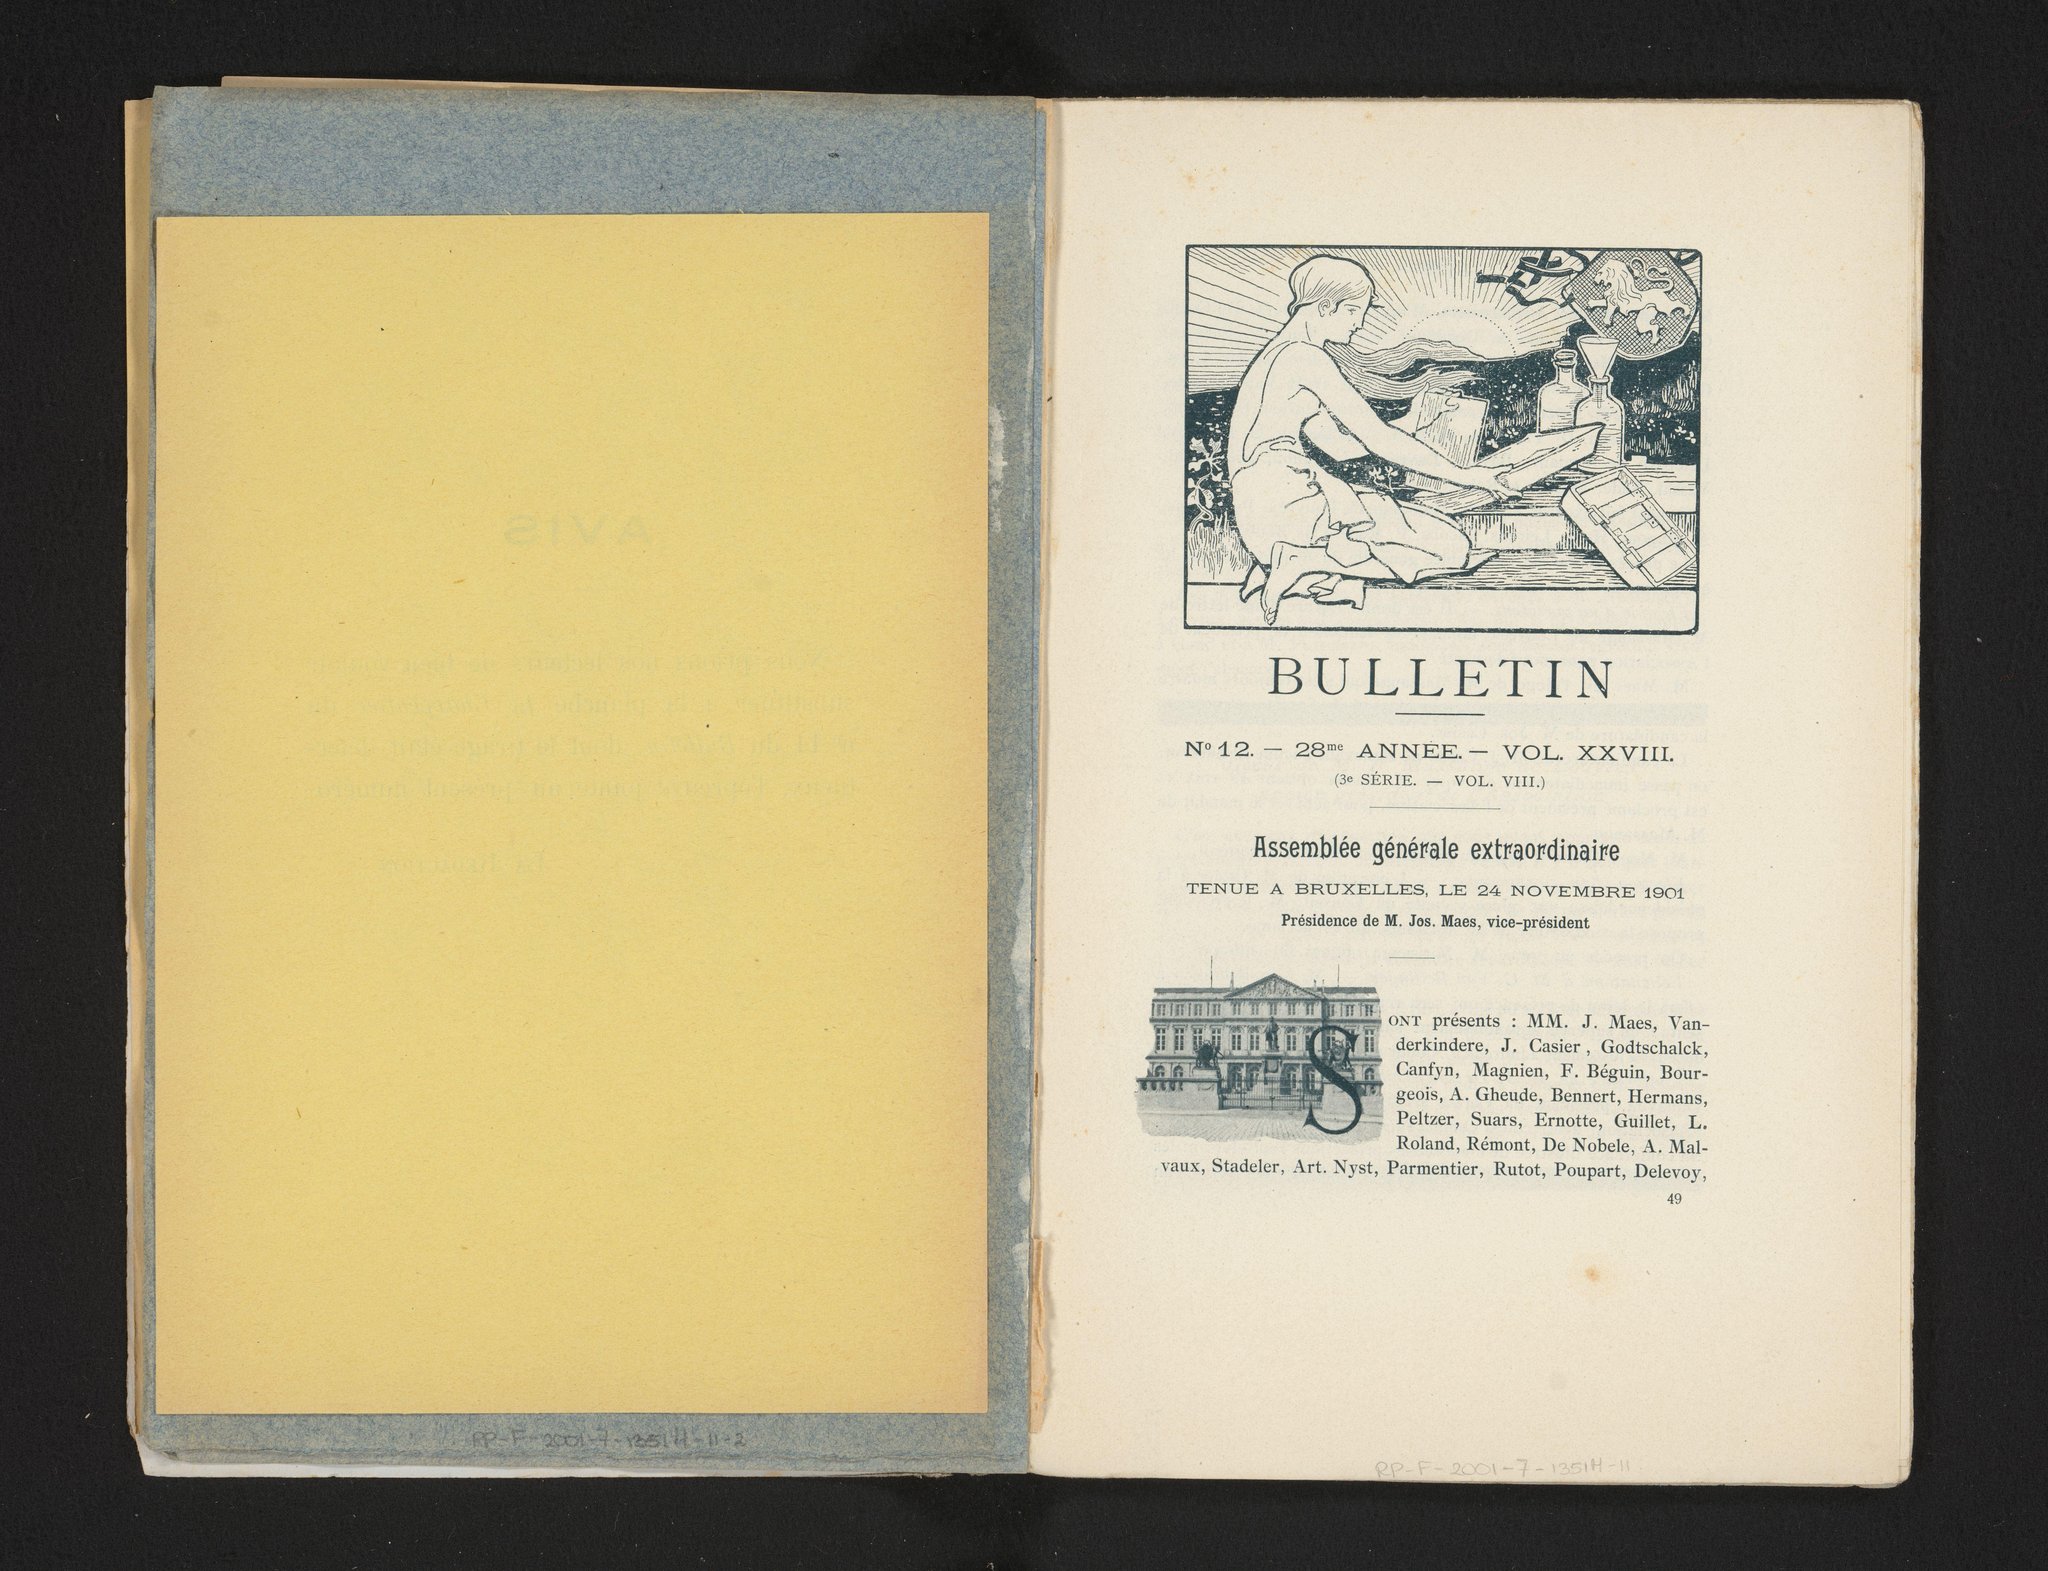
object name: book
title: Bulletin / Association belge de photographie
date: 1901-1912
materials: paper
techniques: printing, engraving